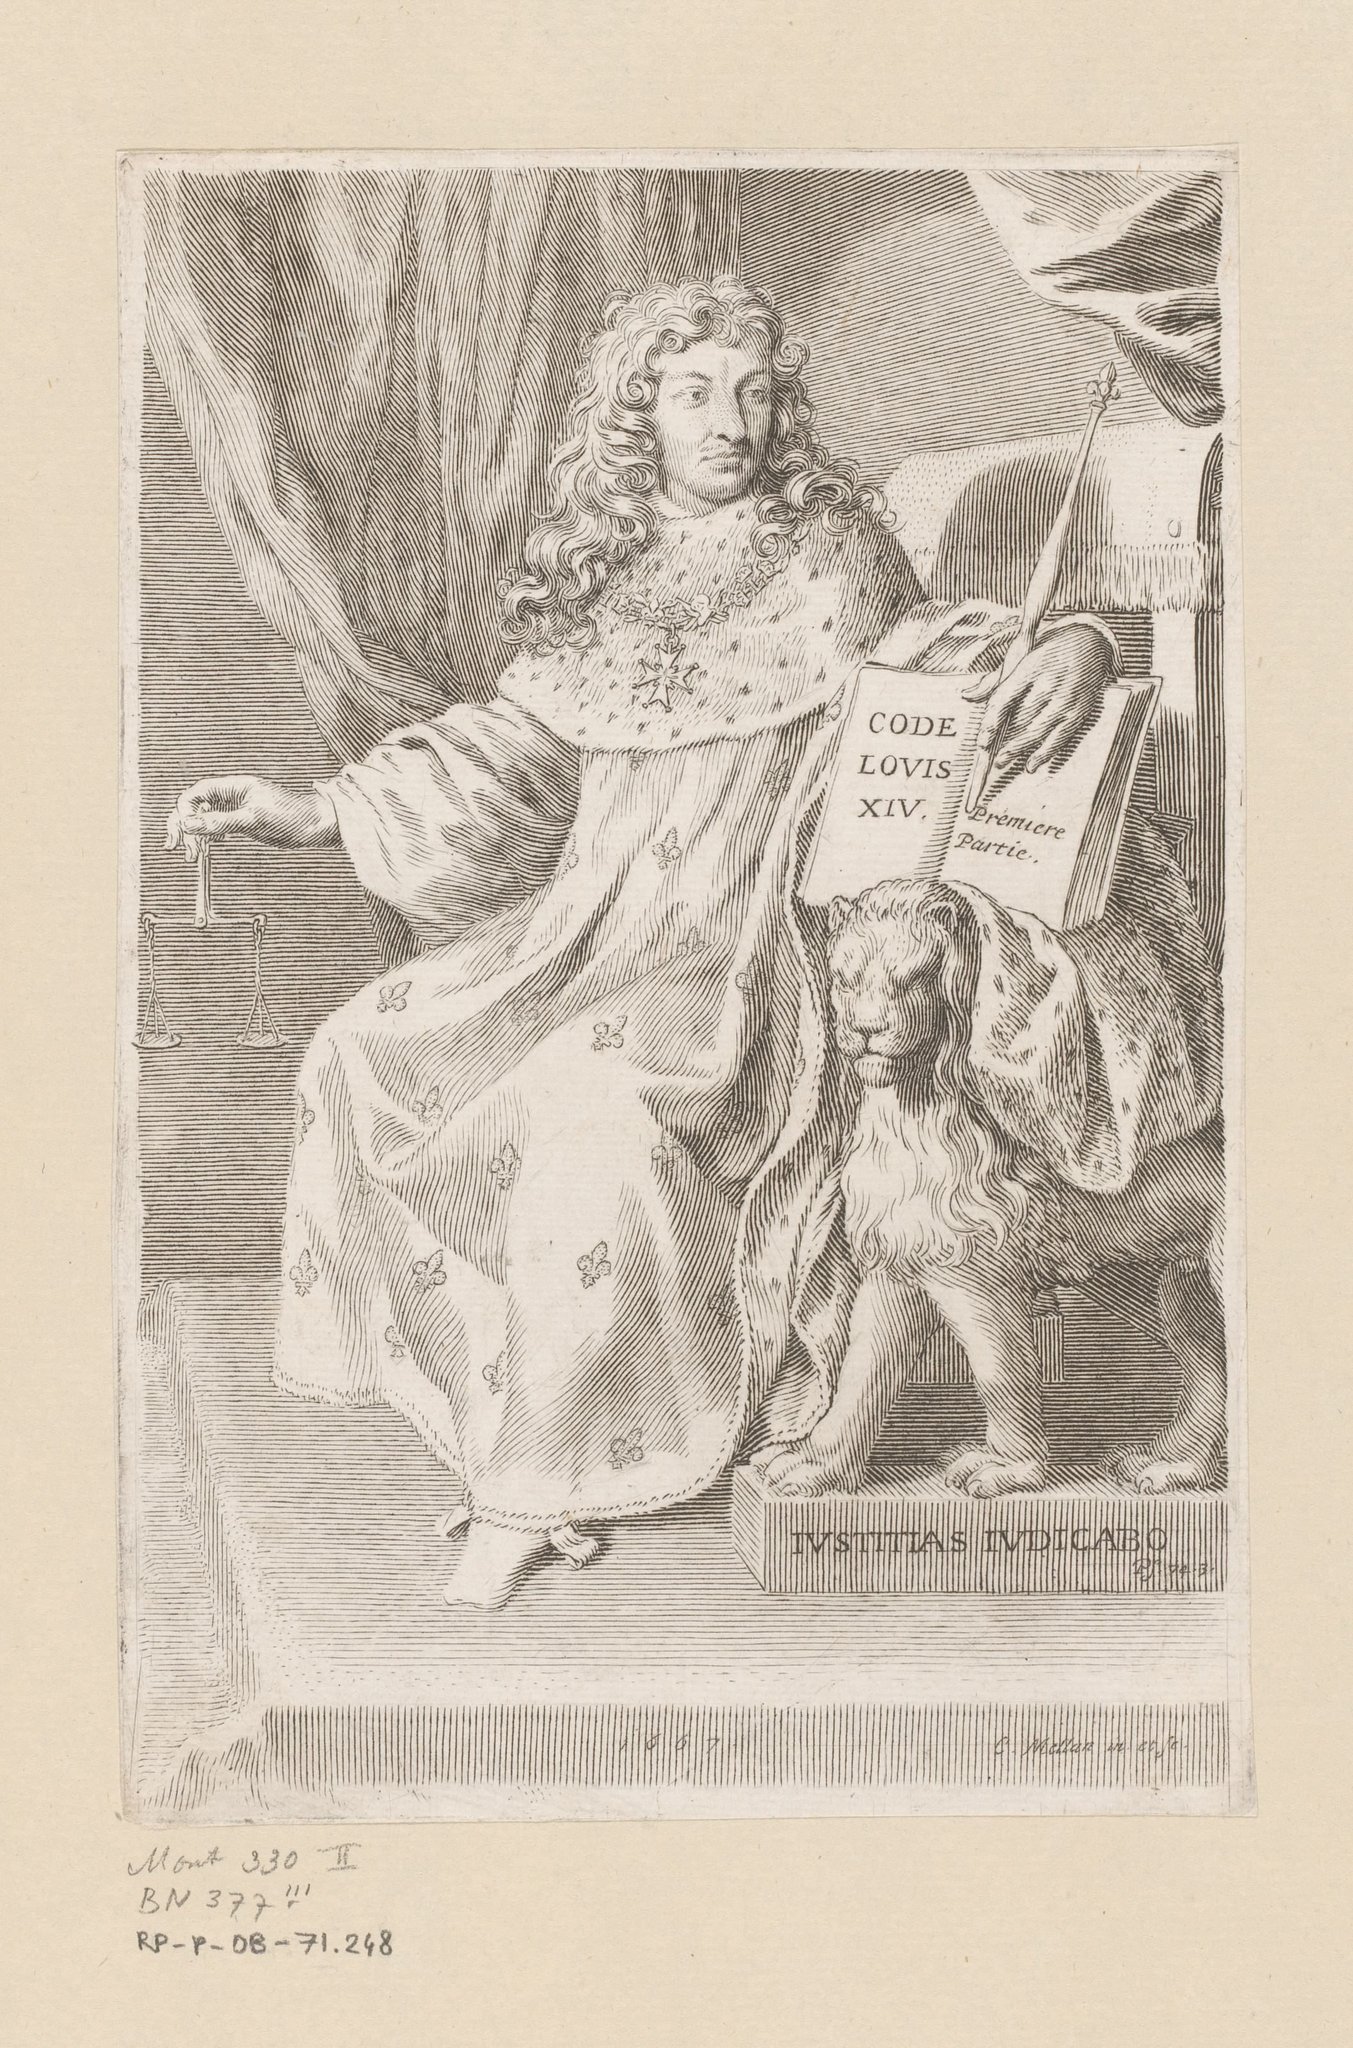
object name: print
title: Titelpagina voor: Code Louis XIV, 1667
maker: claude mellan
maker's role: draughtsman, print maker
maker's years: 1598-1688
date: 1667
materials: paper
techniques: engraving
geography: france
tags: lodewijk xiv (koning van frankrijk), historical persons, throne, king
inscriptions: collector's mark: Lugt 240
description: Titelpagina voor een onbekend boek, getiteld 'Code Louis XIV', uit 1667.